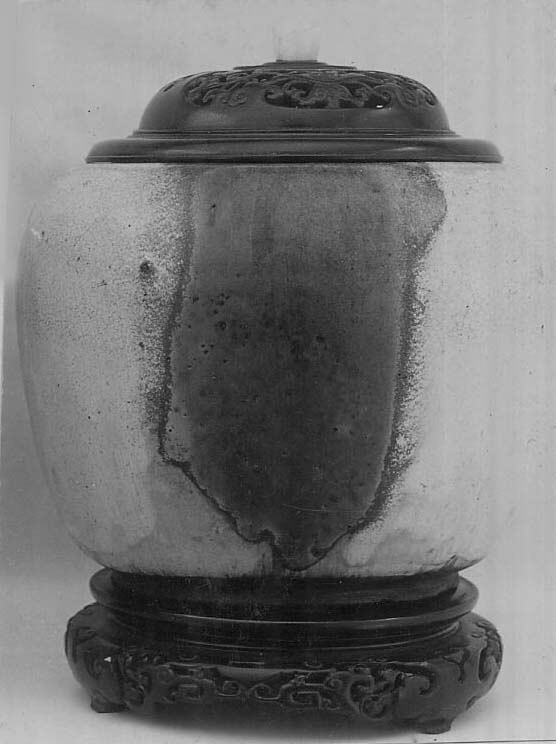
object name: incense burner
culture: japanese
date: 1801-1900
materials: clay, glaze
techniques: overglaze